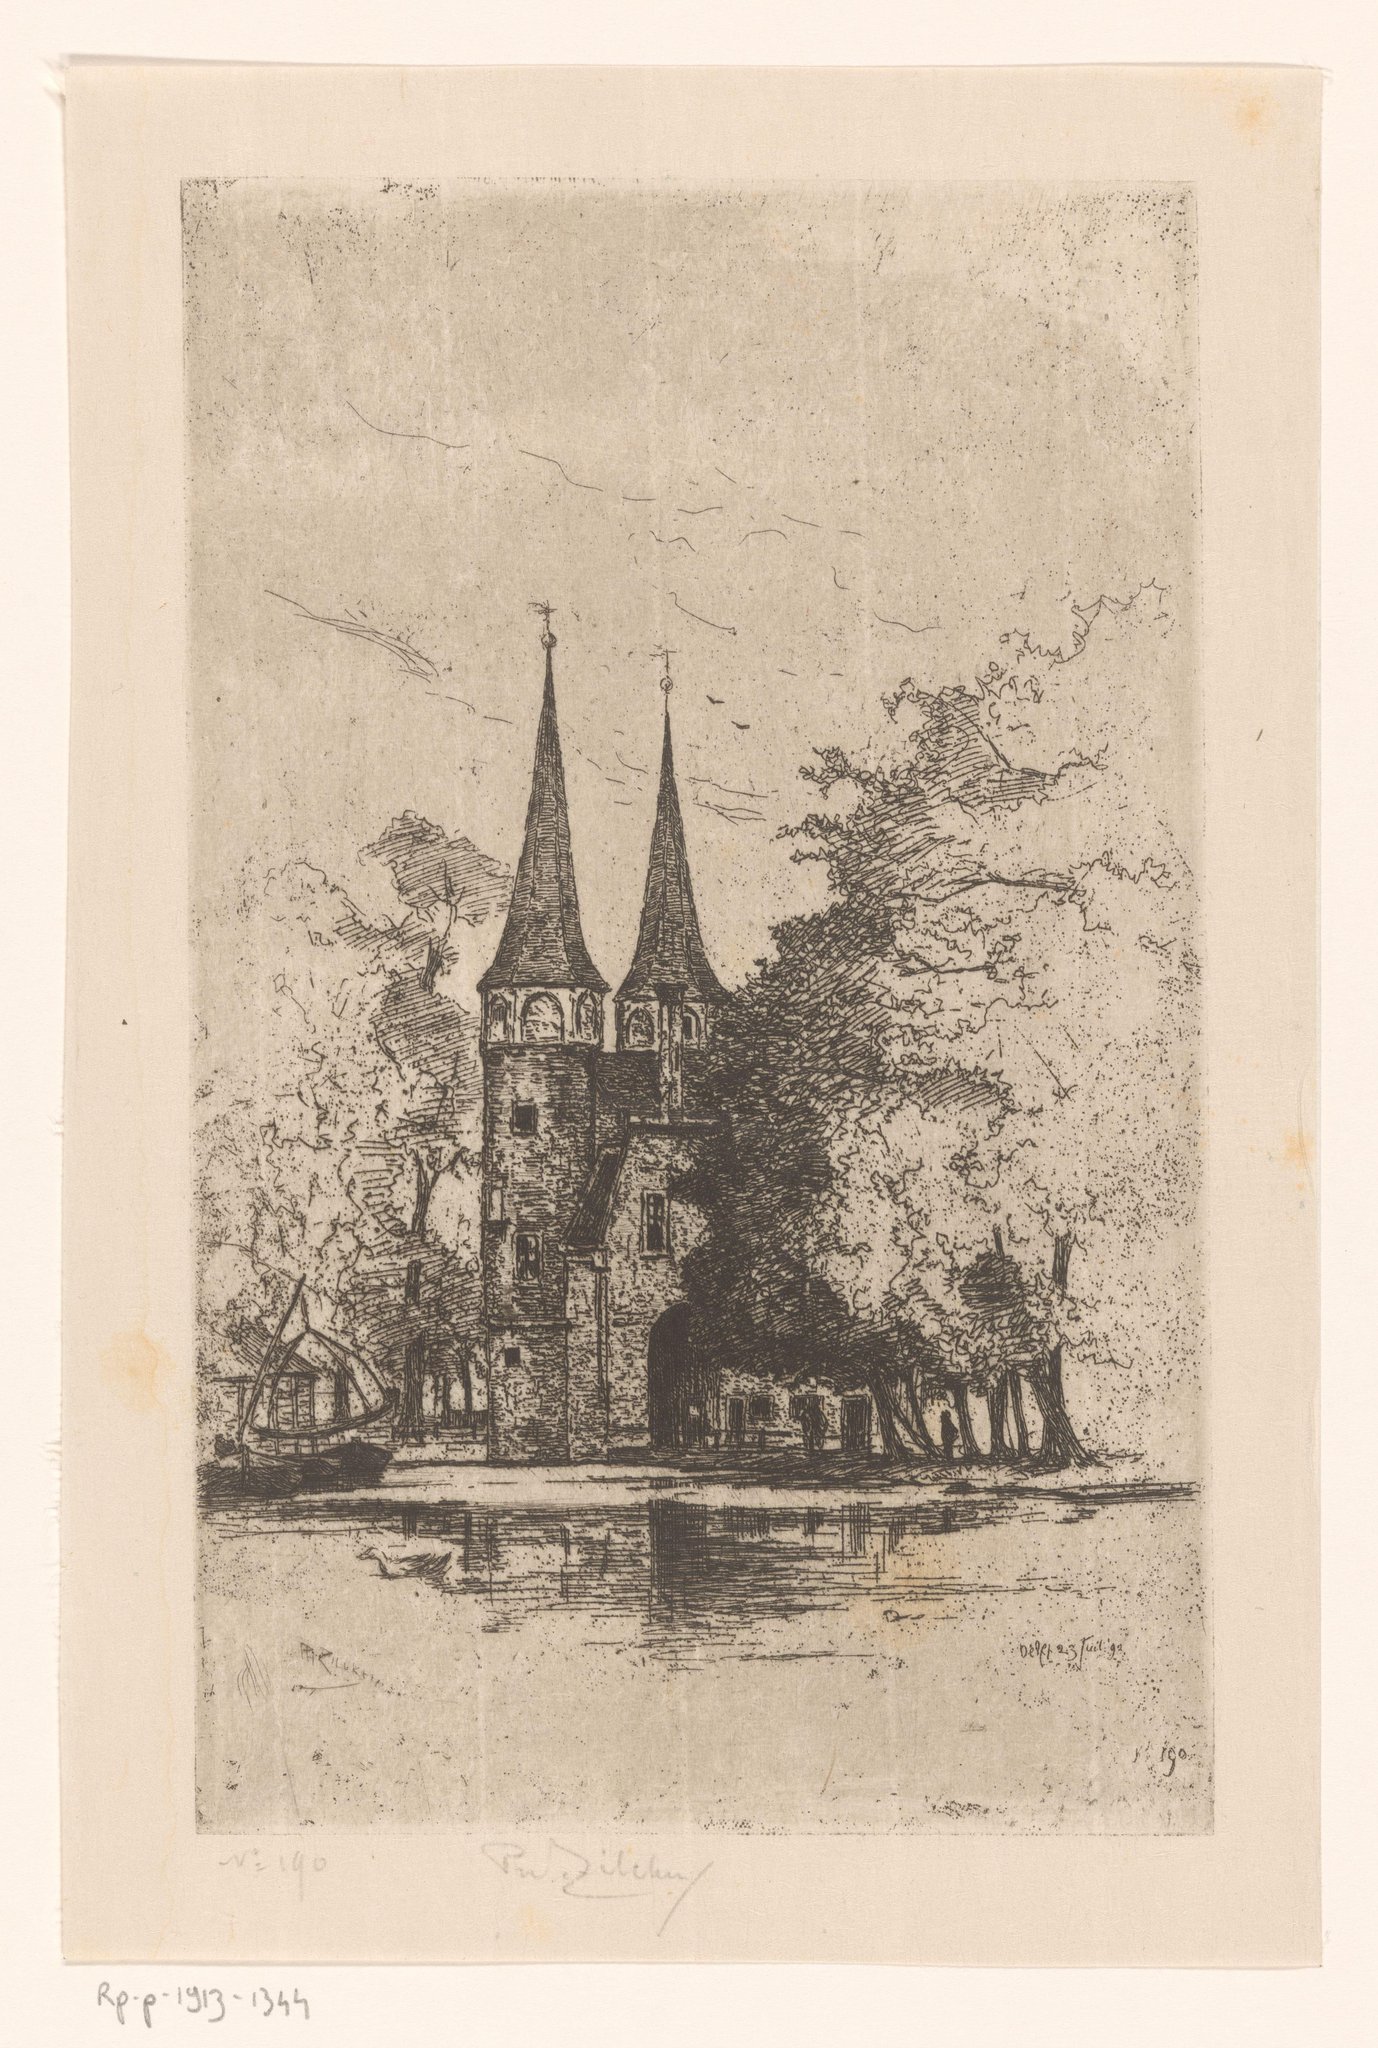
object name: print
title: Gezicht op de Oostpoort, te Delft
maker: philip zilcken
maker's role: draughtsman, painter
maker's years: 1857-1930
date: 1890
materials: paper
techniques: etching, intaglio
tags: city-gate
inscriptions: collector's mark: Lugt 2233